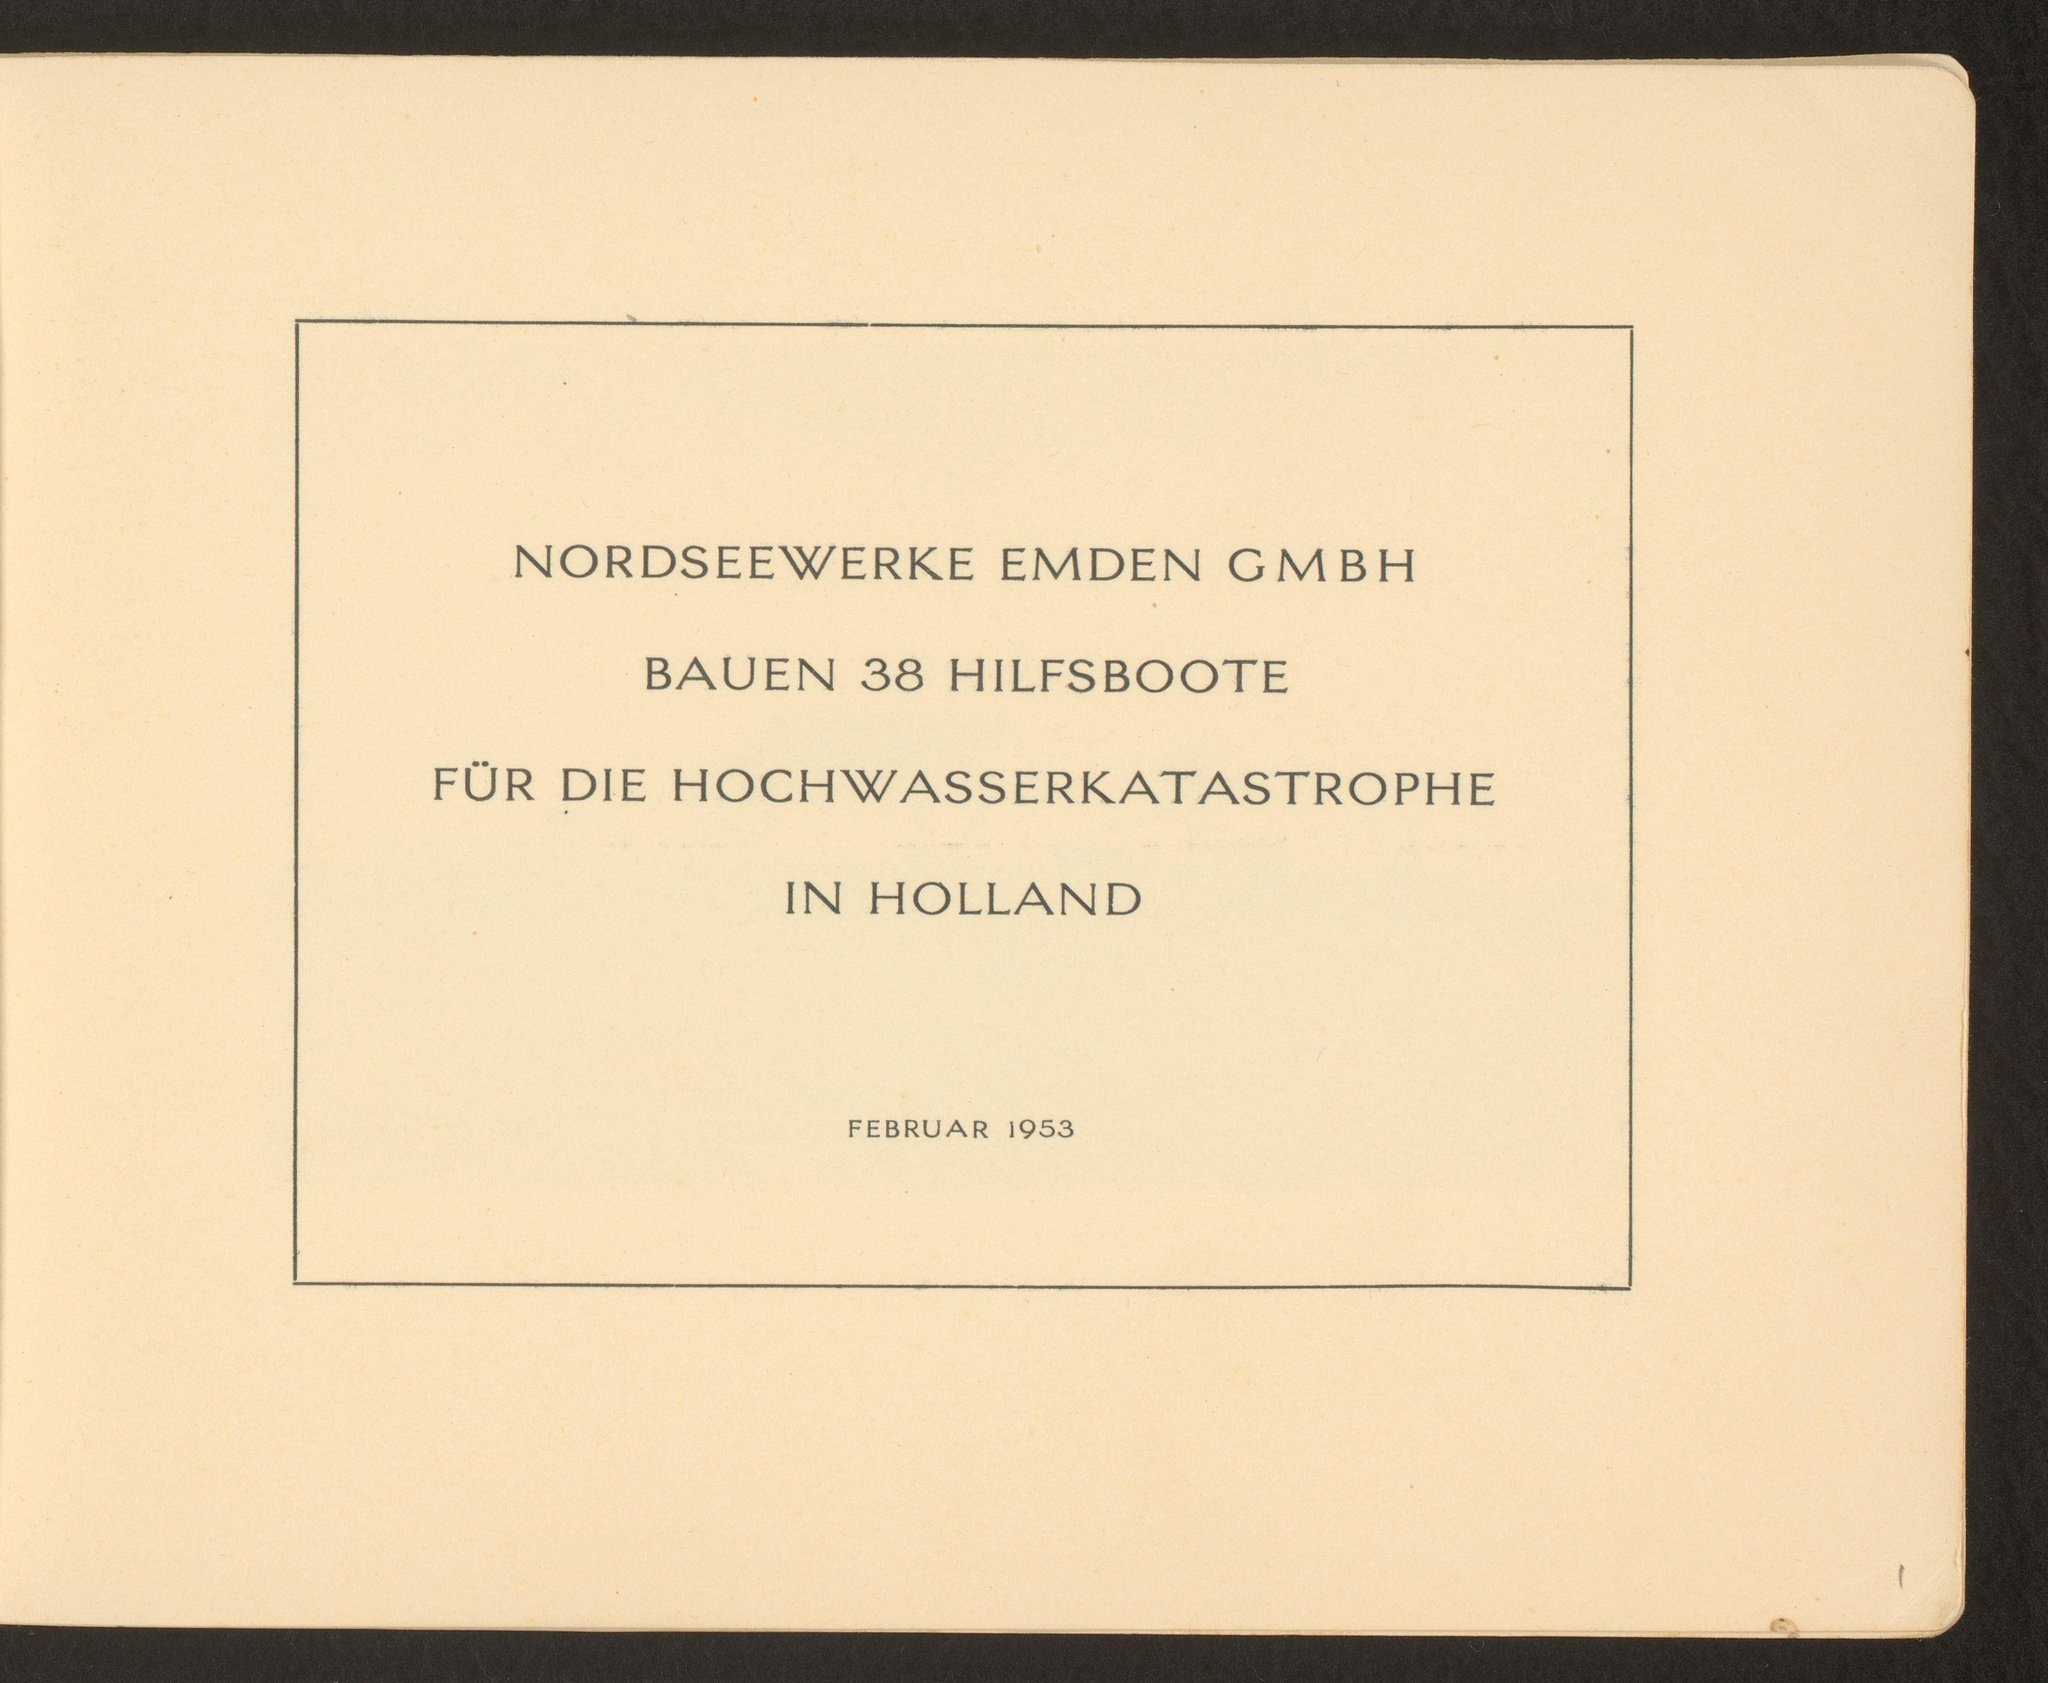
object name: text sheet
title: Nordseewerke Emden GMBH bauen 38 Hilfsboote für die Hochwasserkatastrophe in Holland. Februar 1953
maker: Anonymous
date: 1902-1953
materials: paper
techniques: printing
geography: emden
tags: north sea flood of 1953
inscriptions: date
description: Titelpagina met de gedrukte tekst 'Nordseewerke Emden GMBH bauen 38 Hilfsboote für die Hochwasserkatastrophe in Holland. Februar 1953'. Onderdeel van het fotoalbum 'Emden hilft Holland'.